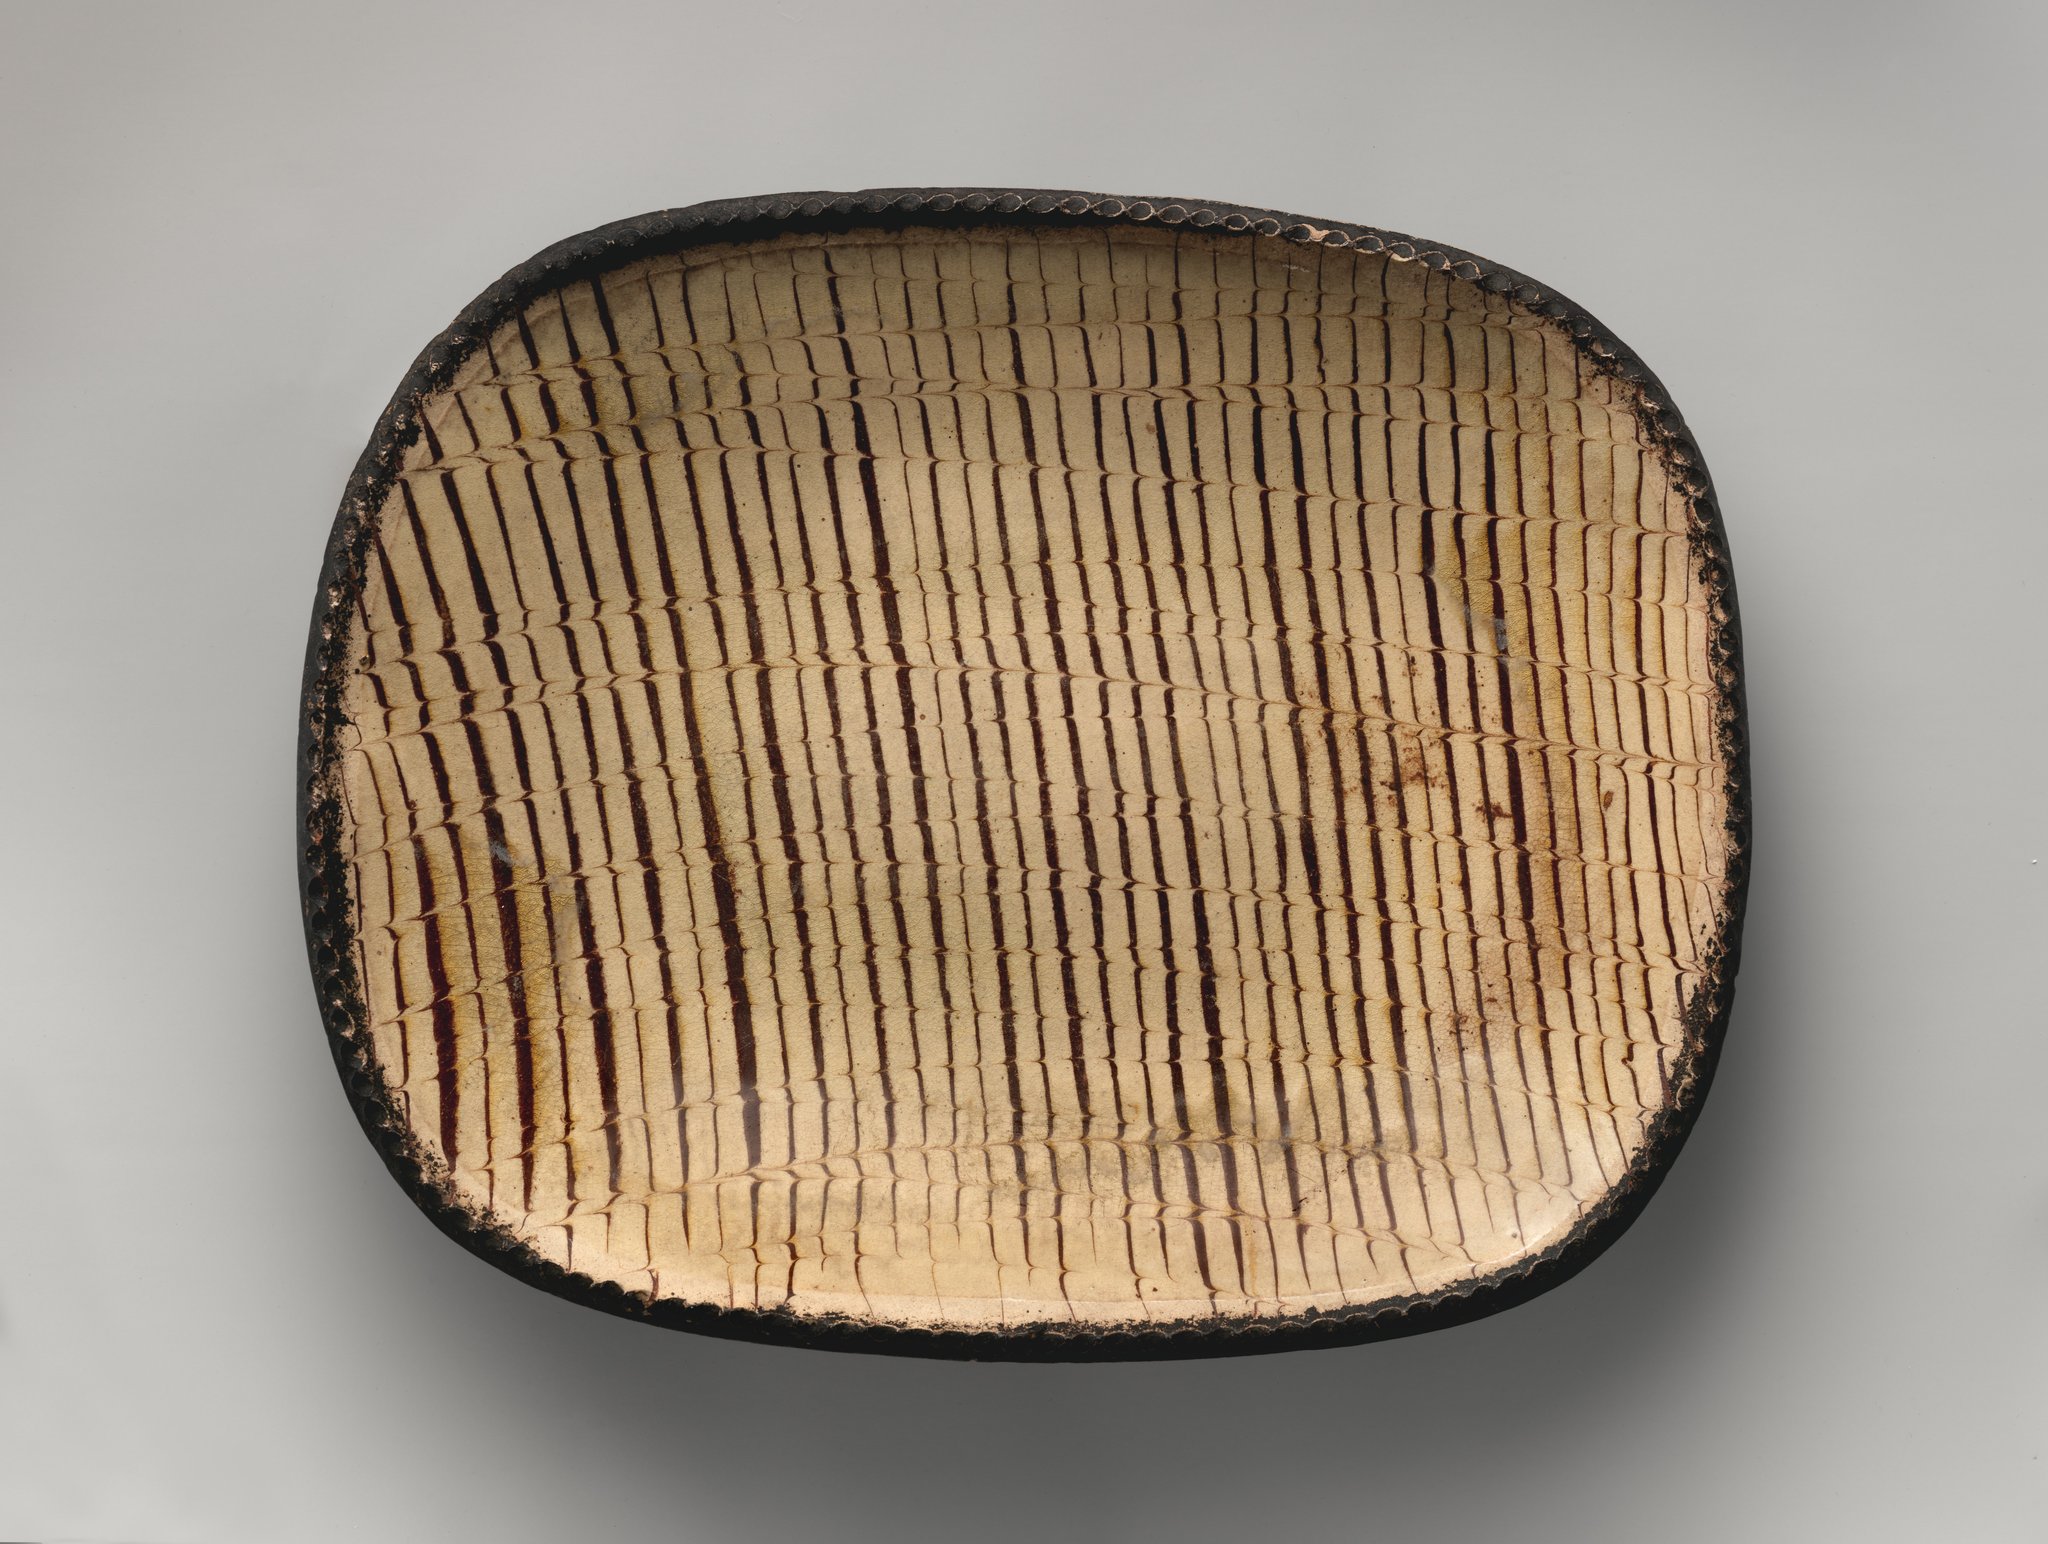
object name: dish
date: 1800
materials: earthenware